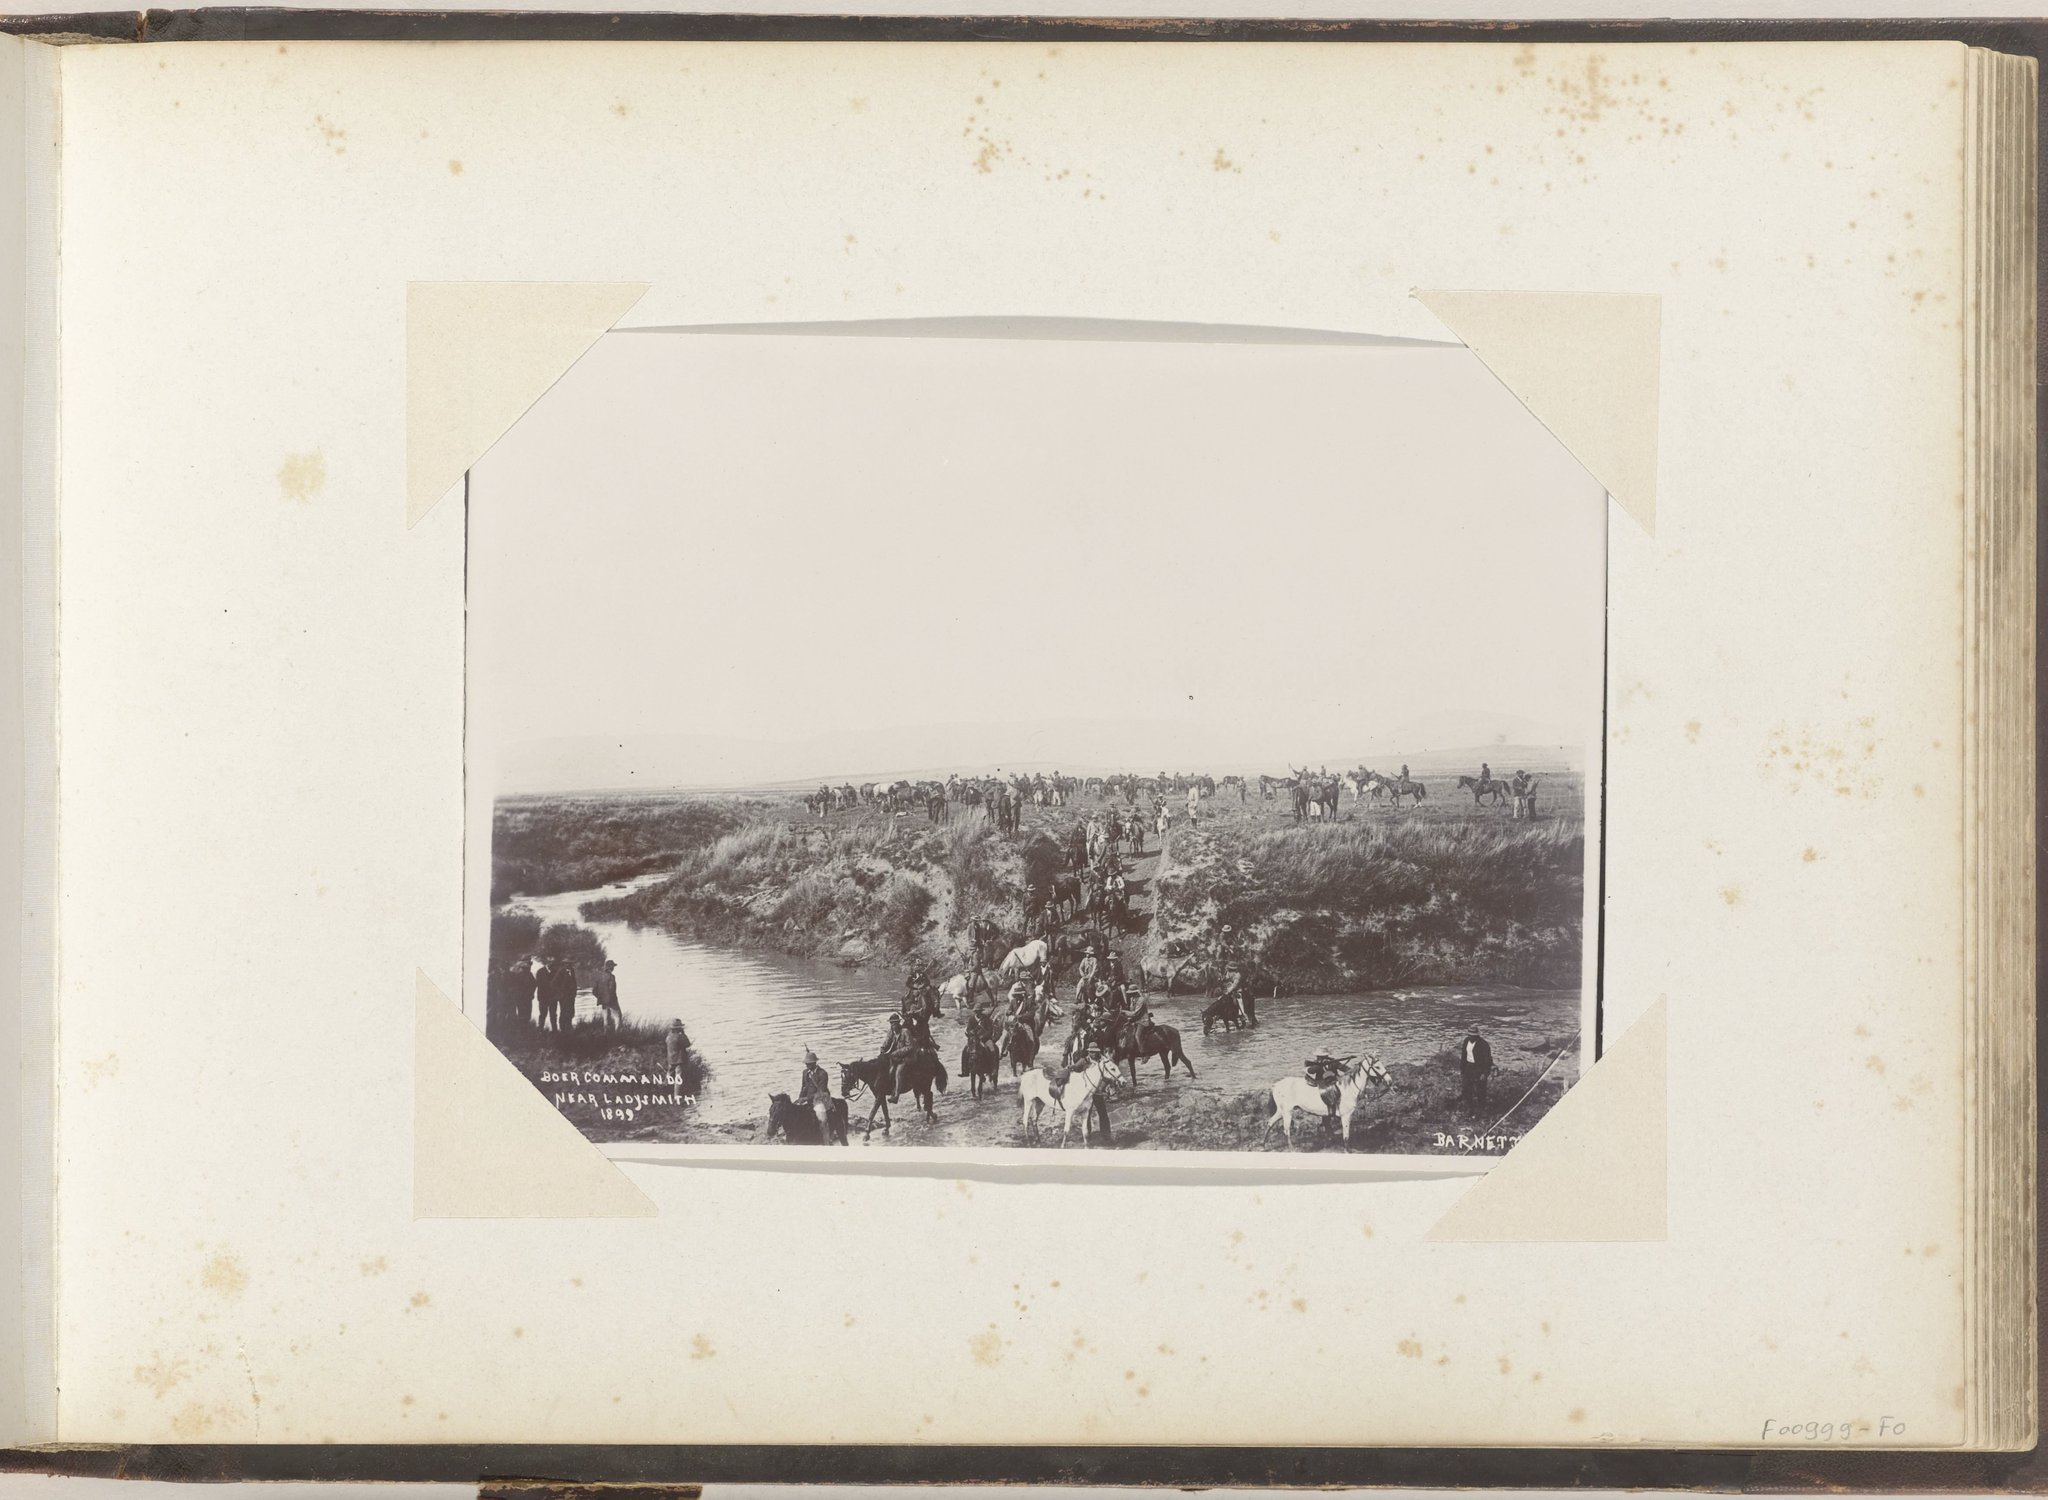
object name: photograph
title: Legereenheid van Boeren te paard trekt rivier over bij Ladysmith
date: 1899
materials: paper, photographic support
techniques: gelatin silver print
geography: ladysmith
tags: land forces (+ cavalry, horsemen)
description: Onderdeel van Album met 191 foto's van een reis naar en door Zuid-Afrika.